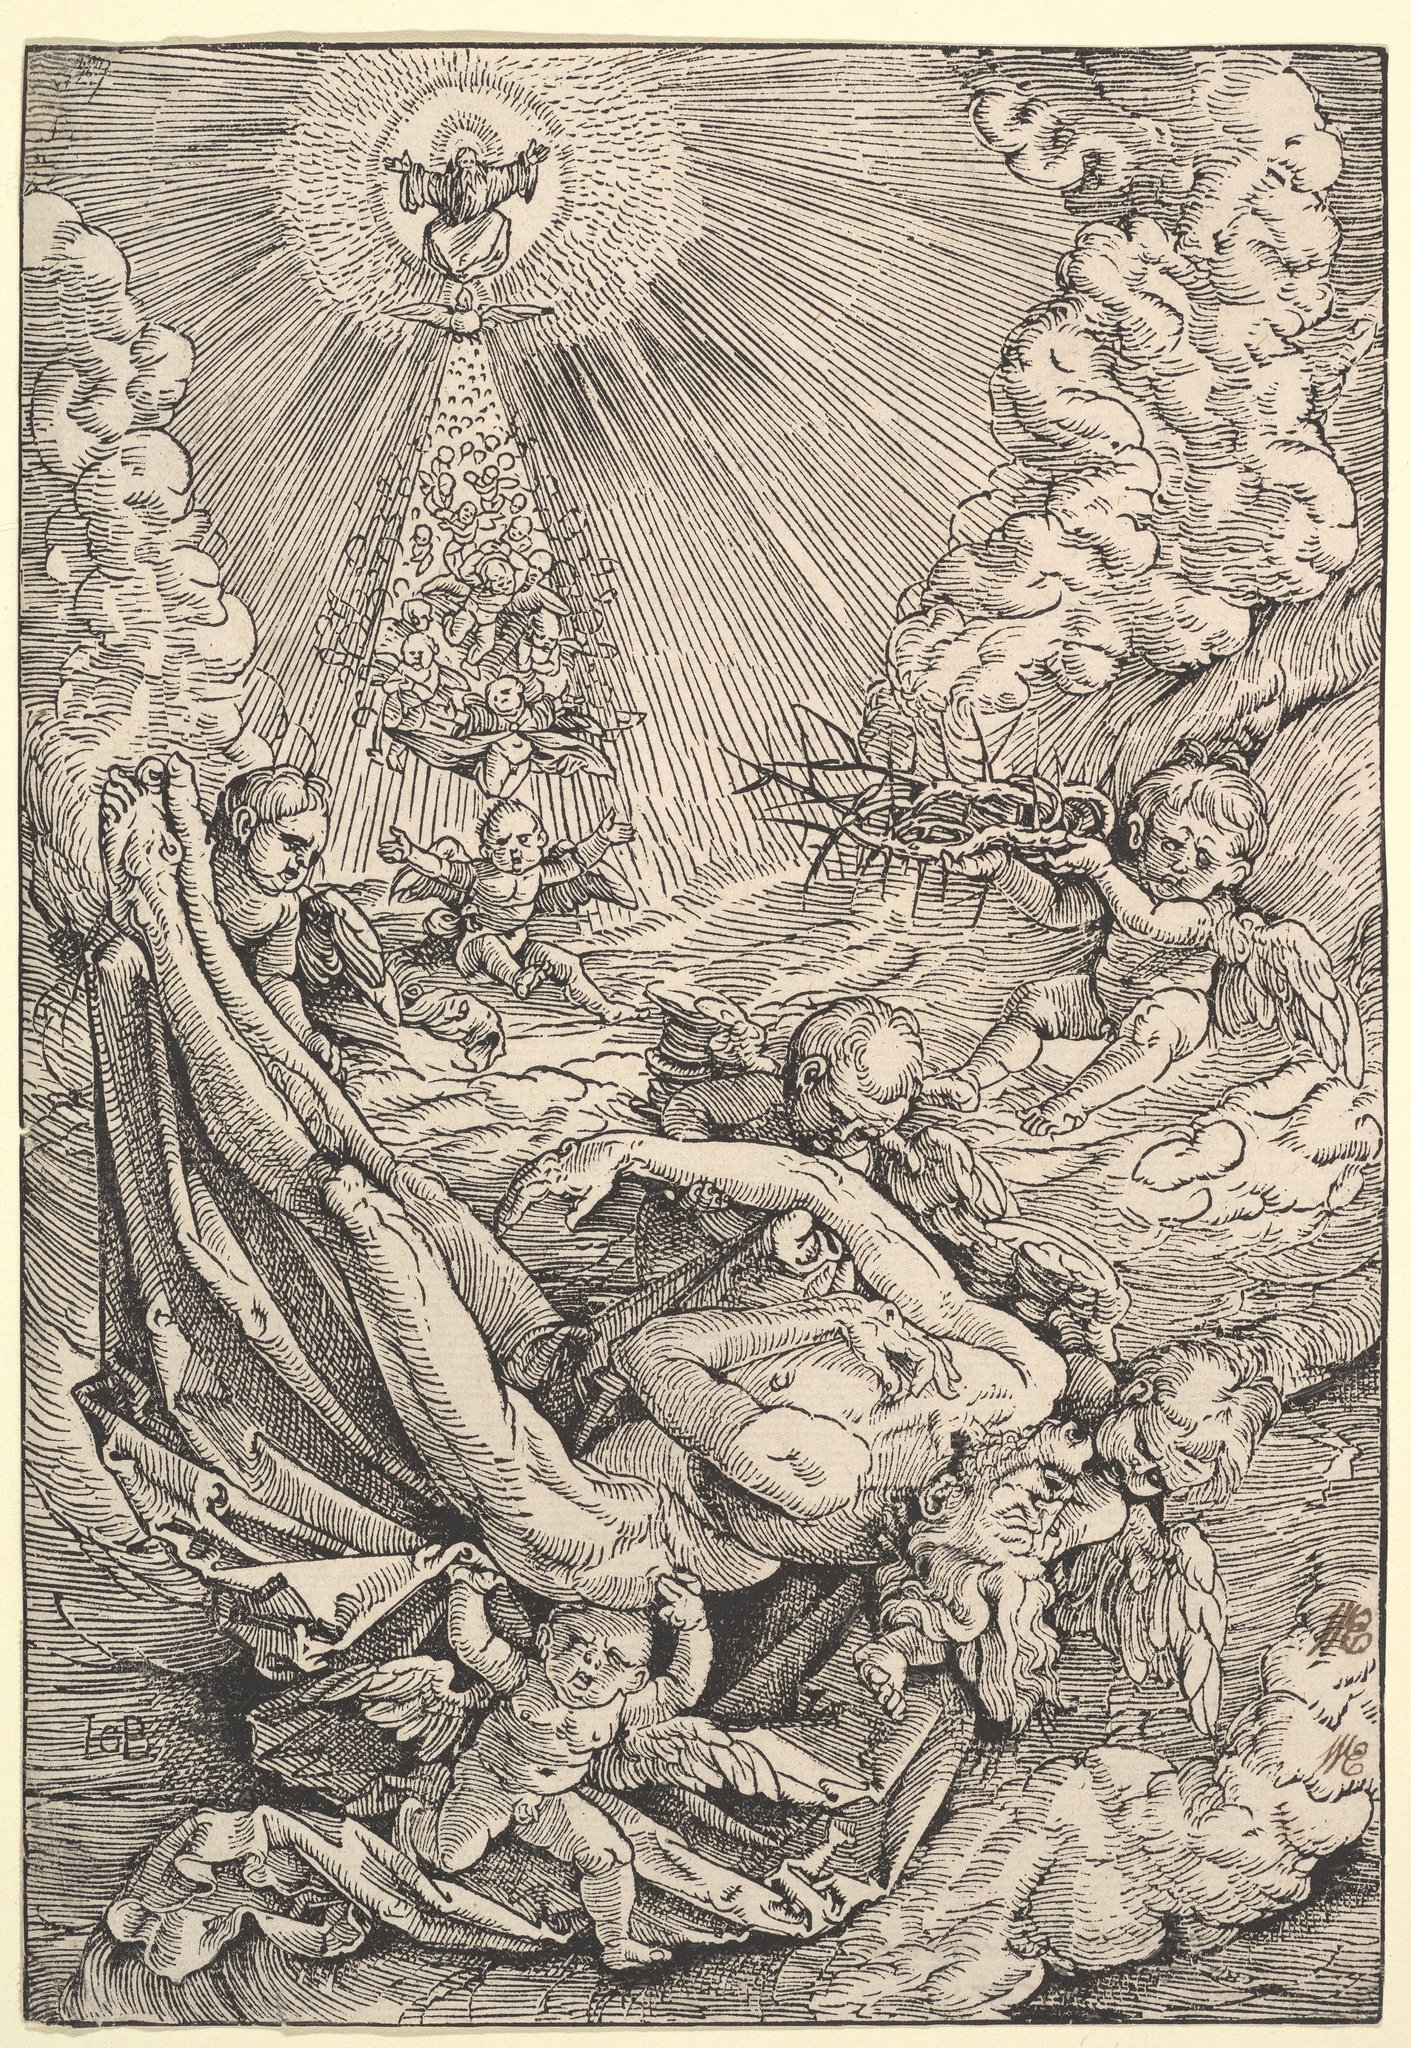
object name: print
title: The Body of Christ Carried by Angels towards Heaven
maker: hans baldung (called hans baldung grien)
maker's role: artist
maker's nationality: german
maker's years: 1484-1545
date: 1516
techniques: woodcut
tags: angels,christ,heaven